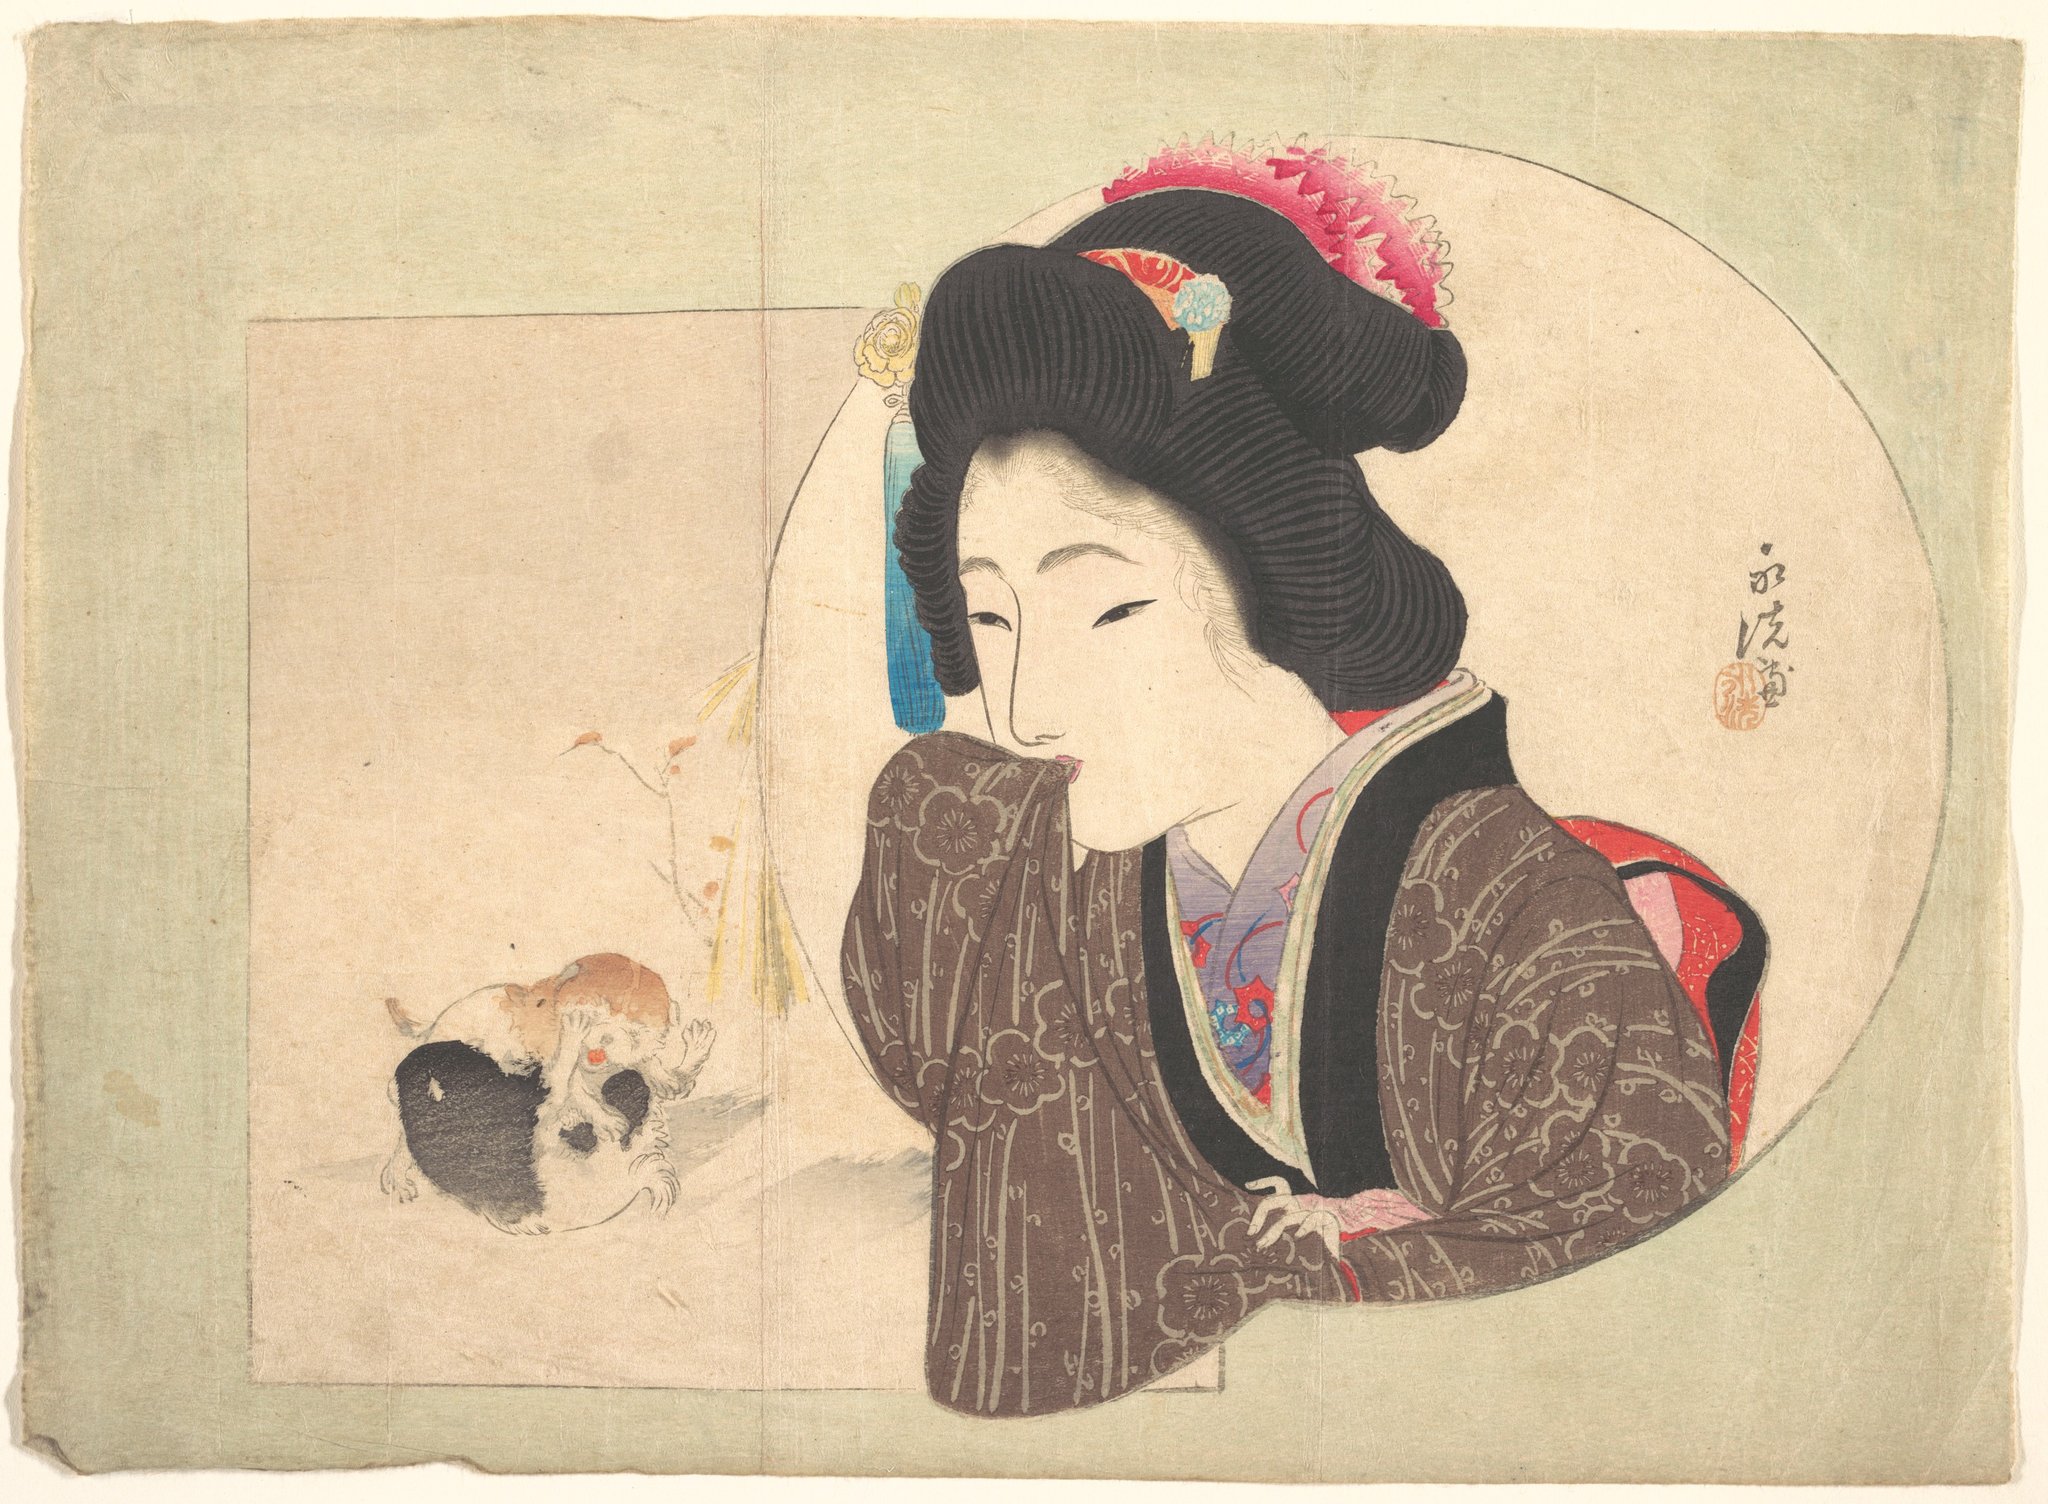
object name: print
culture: japanese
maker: keisai eisen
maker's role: artist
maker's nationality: japanese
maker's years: 1790-1848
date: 1790-1848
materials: ink, paper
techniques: woodblock print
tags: women,dogs